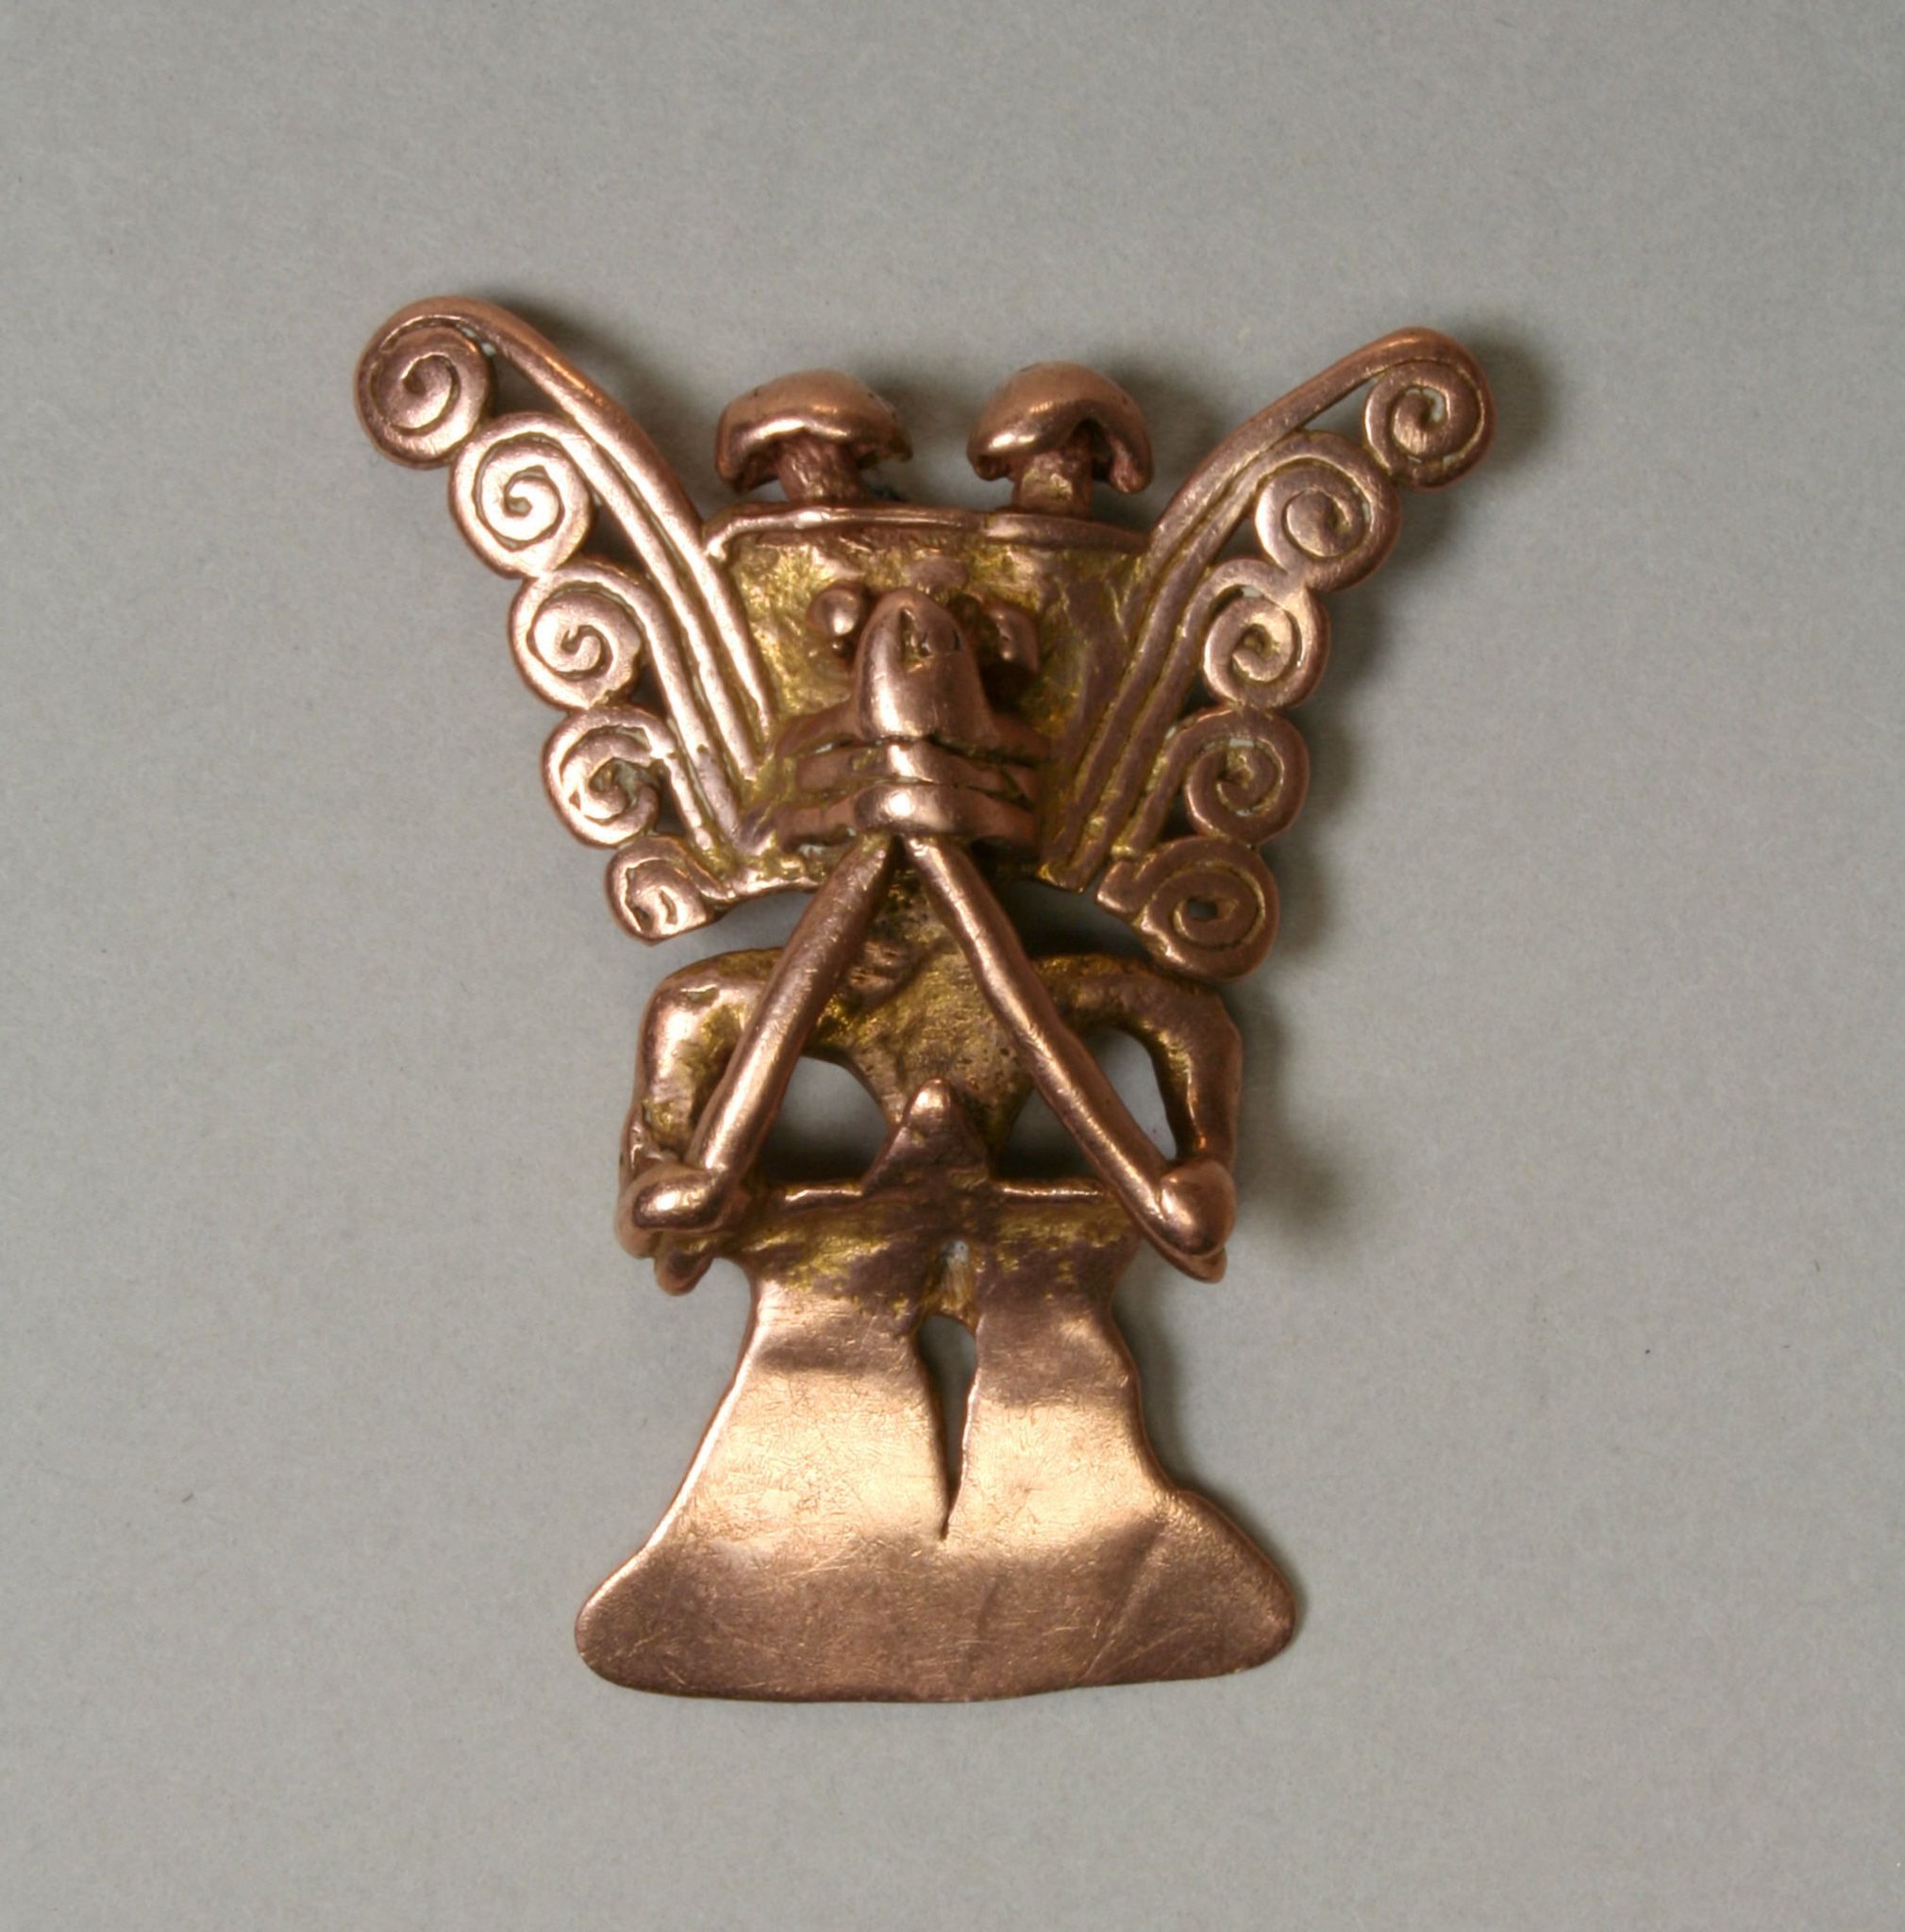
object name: pendant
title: Frog Pendant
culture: darien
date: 901-1600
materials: gold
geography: colombia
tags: frogs